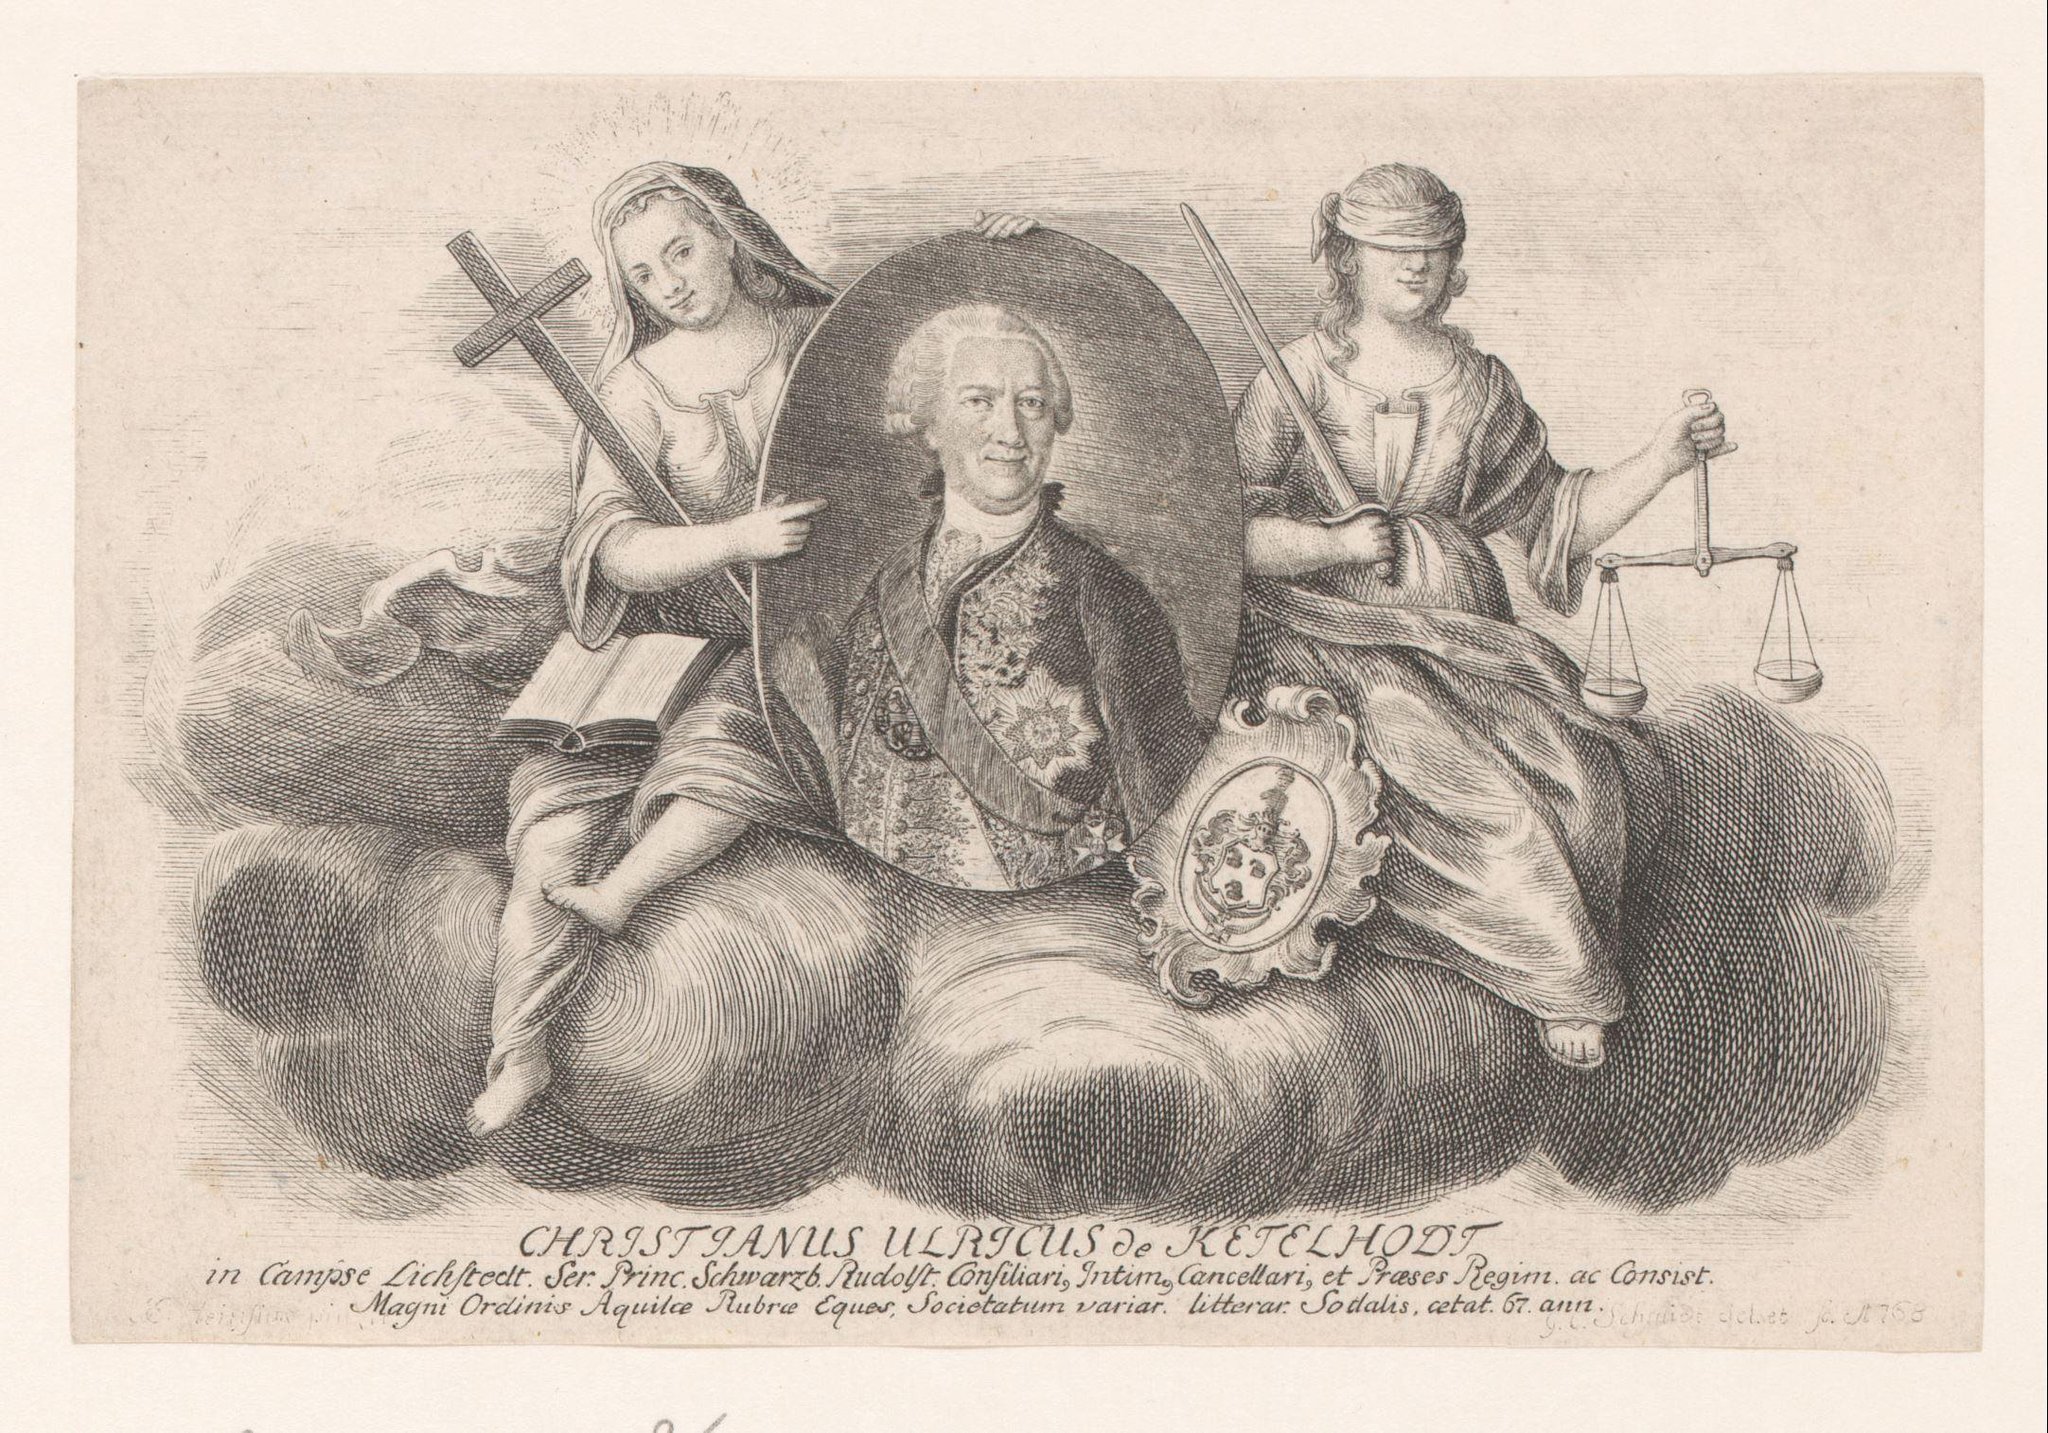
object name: print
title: Portret van Christian Ulrich von Ketelhodt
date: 1768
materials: paper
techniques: etching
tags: devotion, piety; 'divotione' (ripa), historical persons, armorial bearing, heraldry, symbols and allegories of jurisprudence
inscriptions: collector's mark: Lugt 2228